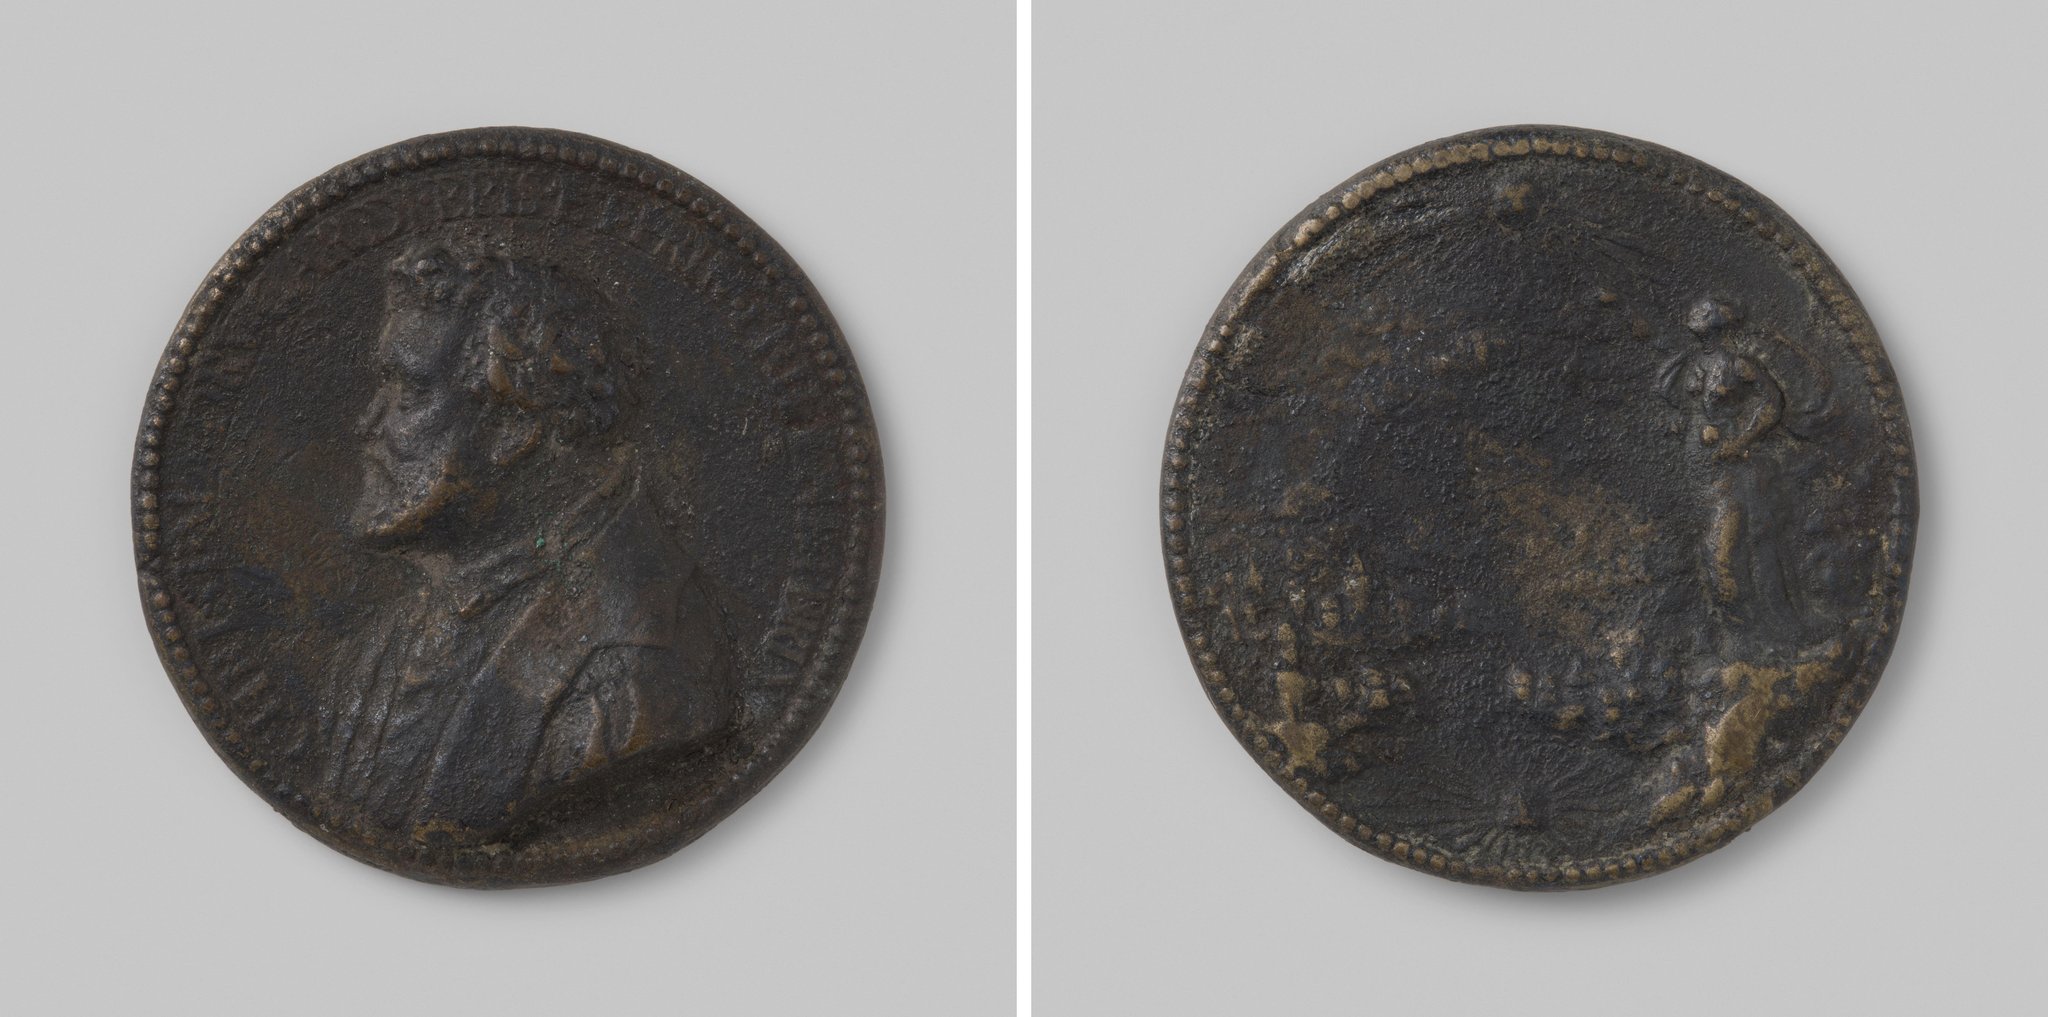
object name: copy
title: Kardinaal Cristoforo Madruzzo, bisschop van Trente en Brixen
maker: Anonymous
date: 1544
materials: bronze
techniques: casting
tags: kardinaal, cristoforo madruzzo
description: Bronzen penning. Voorzijde: borststuk man binnen omschrift. Keerzijde: gezicht op haven, beschenen door zon, die in water wordt weerkaatst; op voorgrond rechts op heuvel: stanbeeld dat naar zon wijst